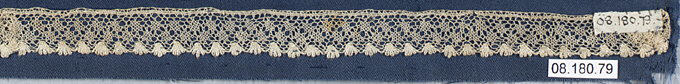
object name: fragment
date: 1801-1900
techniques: lace